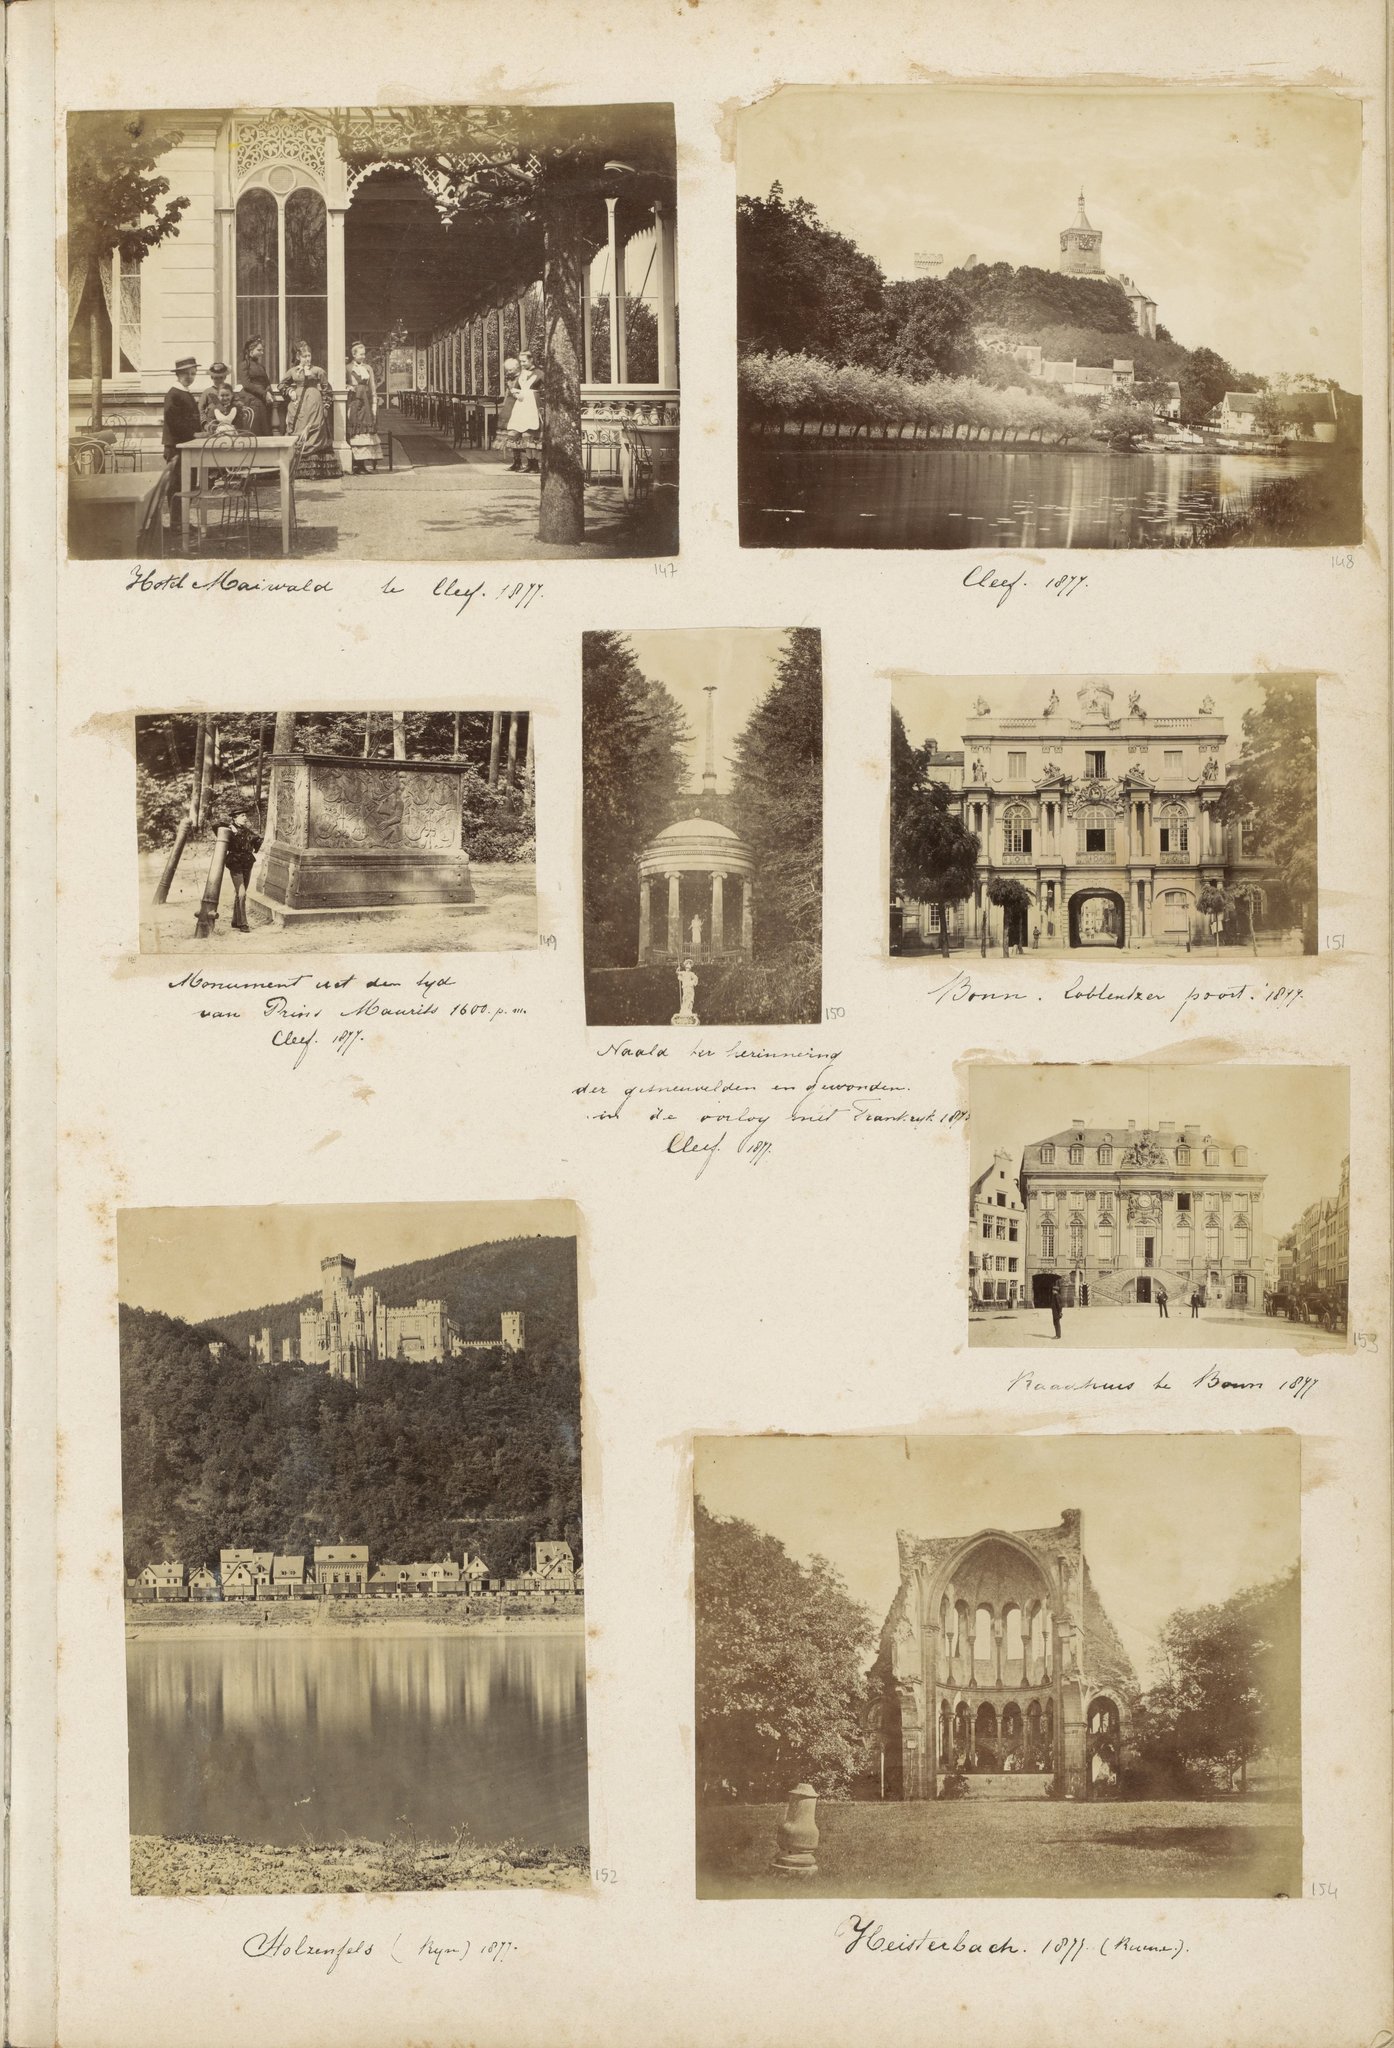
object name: album leaf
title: Gezelschap van vrouwen en kinderen poserend op het terras van Hotel Maywald te Kleef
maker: Anonymous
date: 1877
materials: paper, photographic support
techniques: albumen print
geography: cleves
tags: pavement, terrace in front of inn or restaurant, hotel, hostelry, inn, cleves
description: Onderdeel van Fotoalbum van Robert Daniel Crommelin (1841-1907).